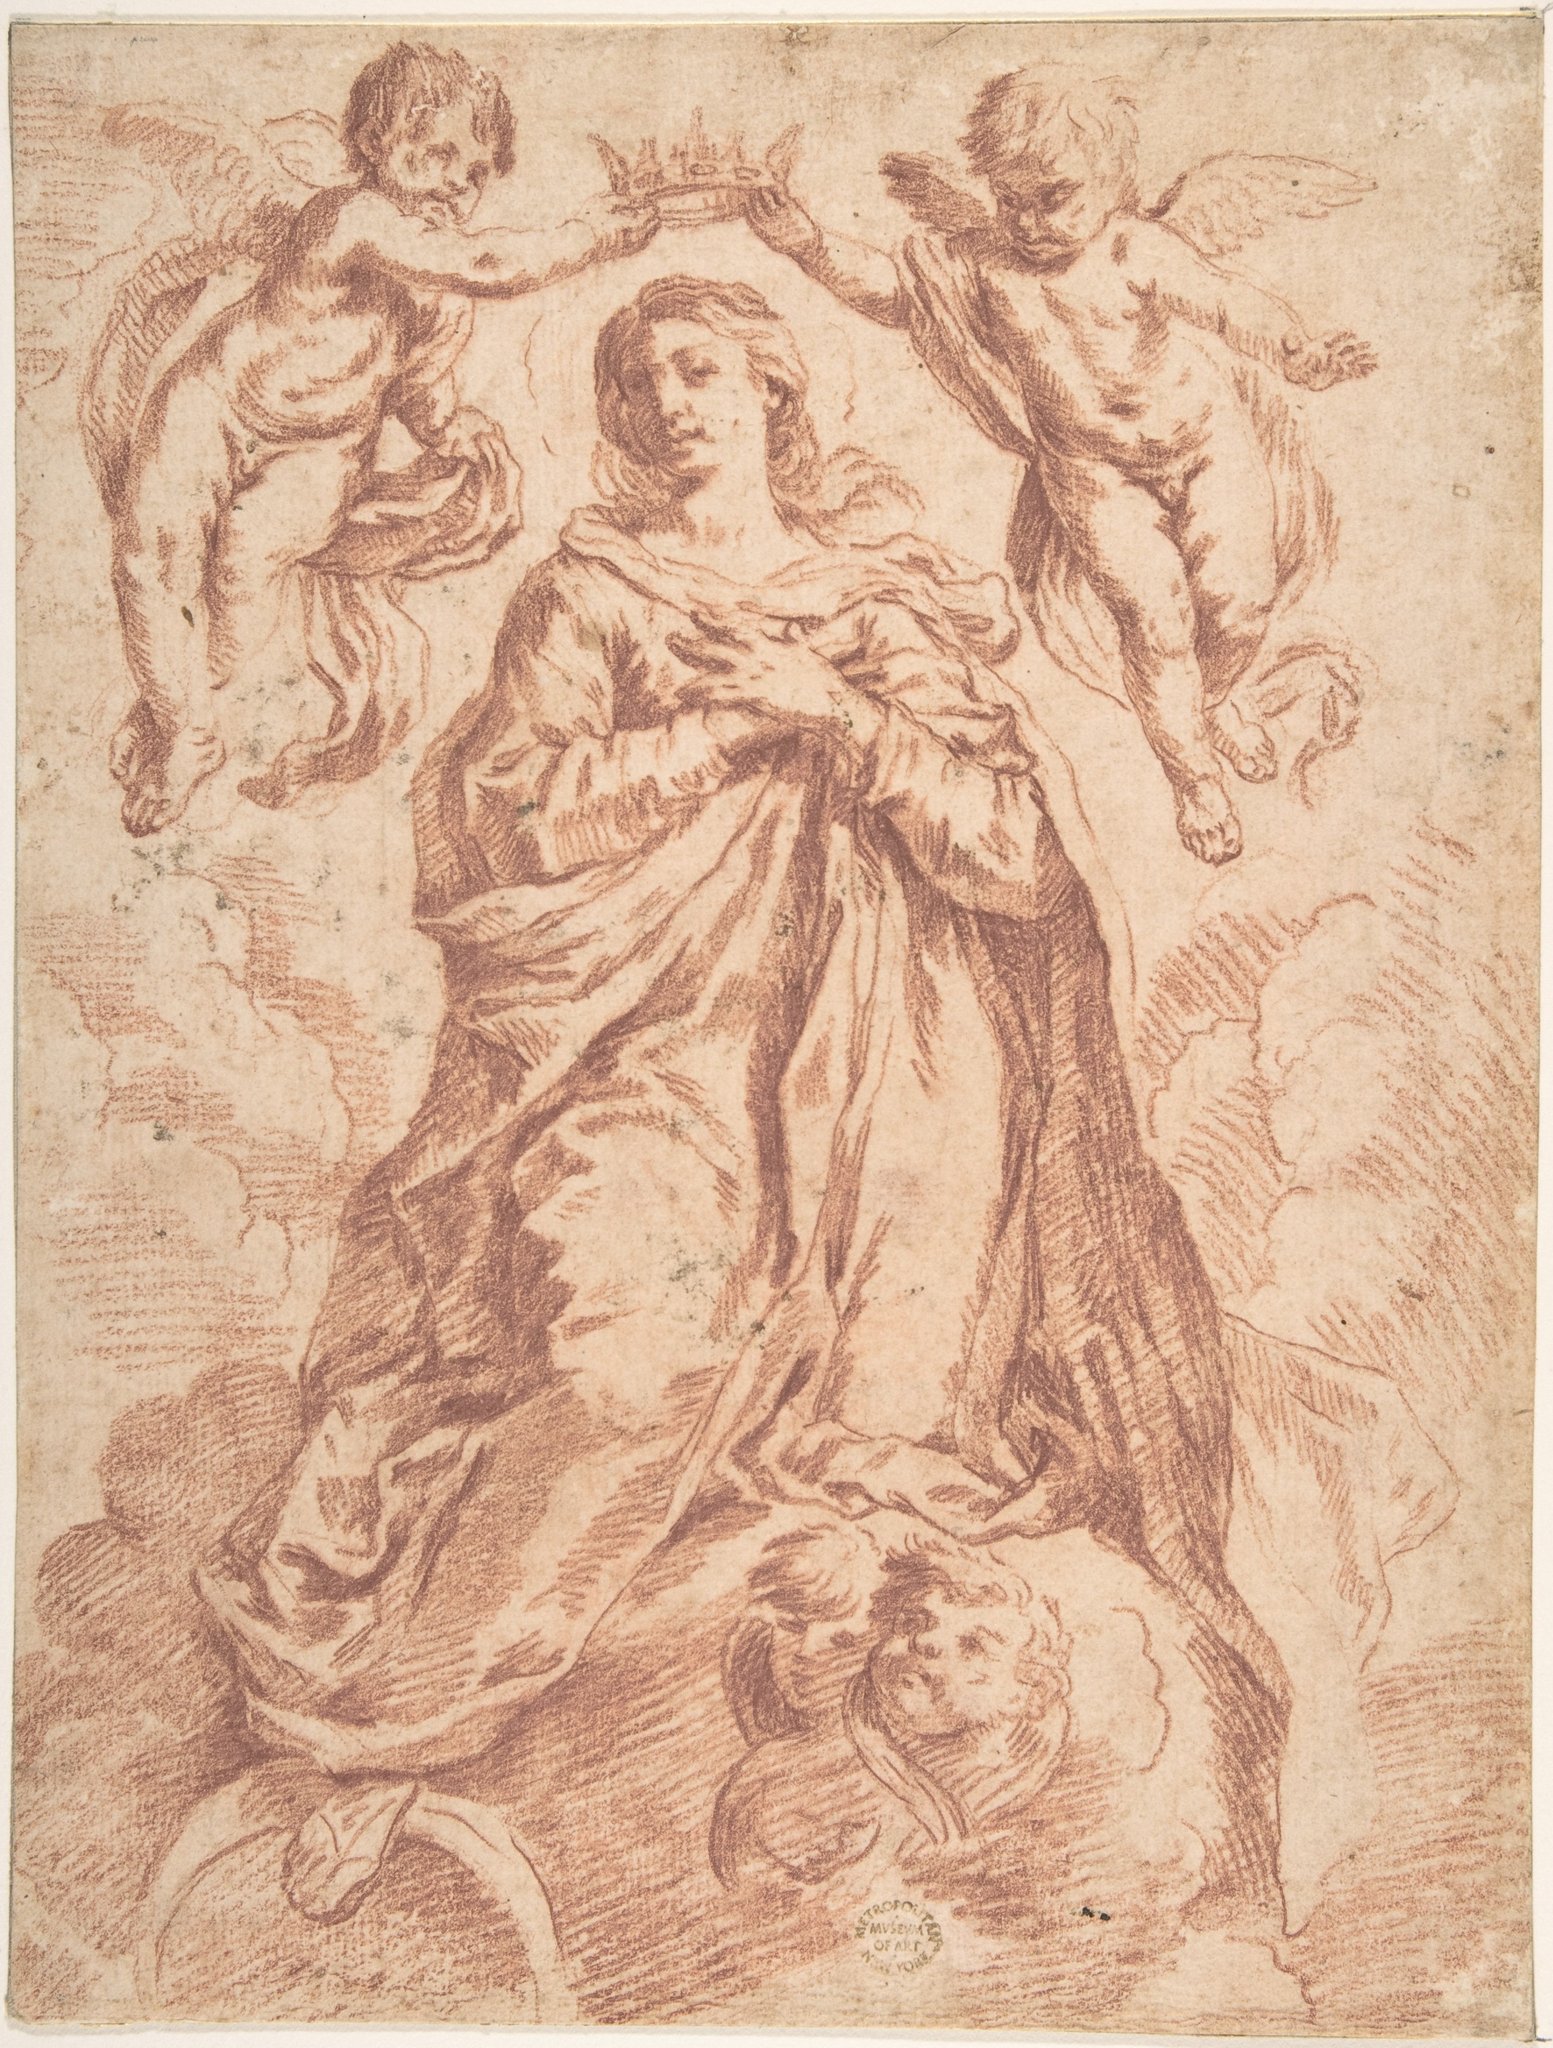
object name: drawing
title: Coronation of the Virgin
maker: anonymous, spanish, 17th century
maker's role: artist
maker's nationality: spanish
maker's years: 1600-1700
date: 1601-1700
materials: chalk, paper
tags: angels,virgin mary